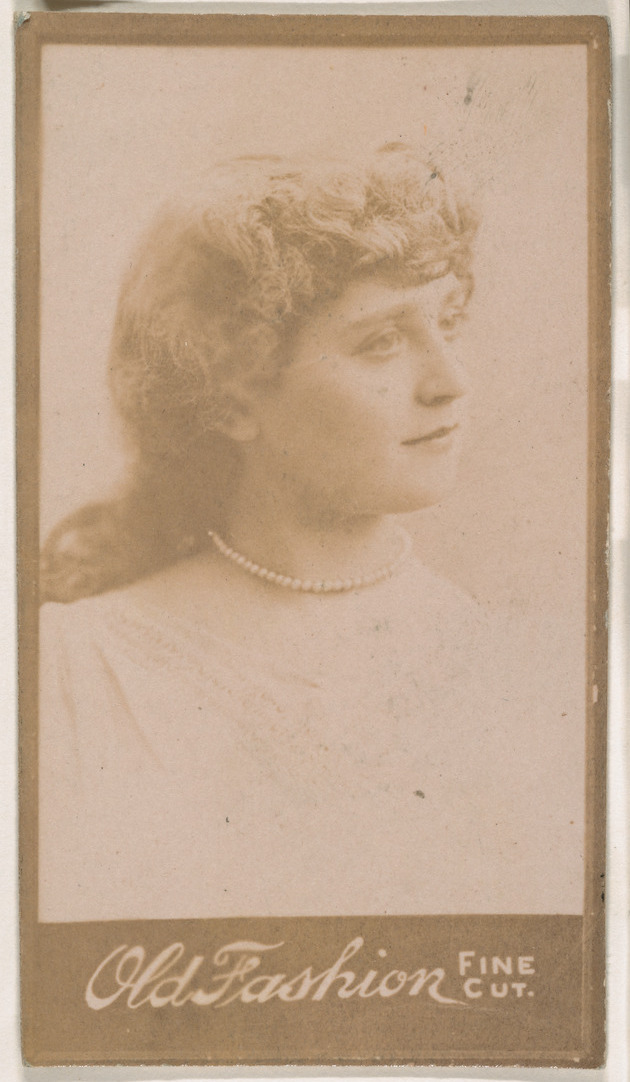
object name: photograph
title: Portrait of actress, from the Actresses series (N664) promoting Old Fashion Fine Cut Tobacco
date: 1888-1890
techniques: albumen silver print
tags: portraits,women,actresses